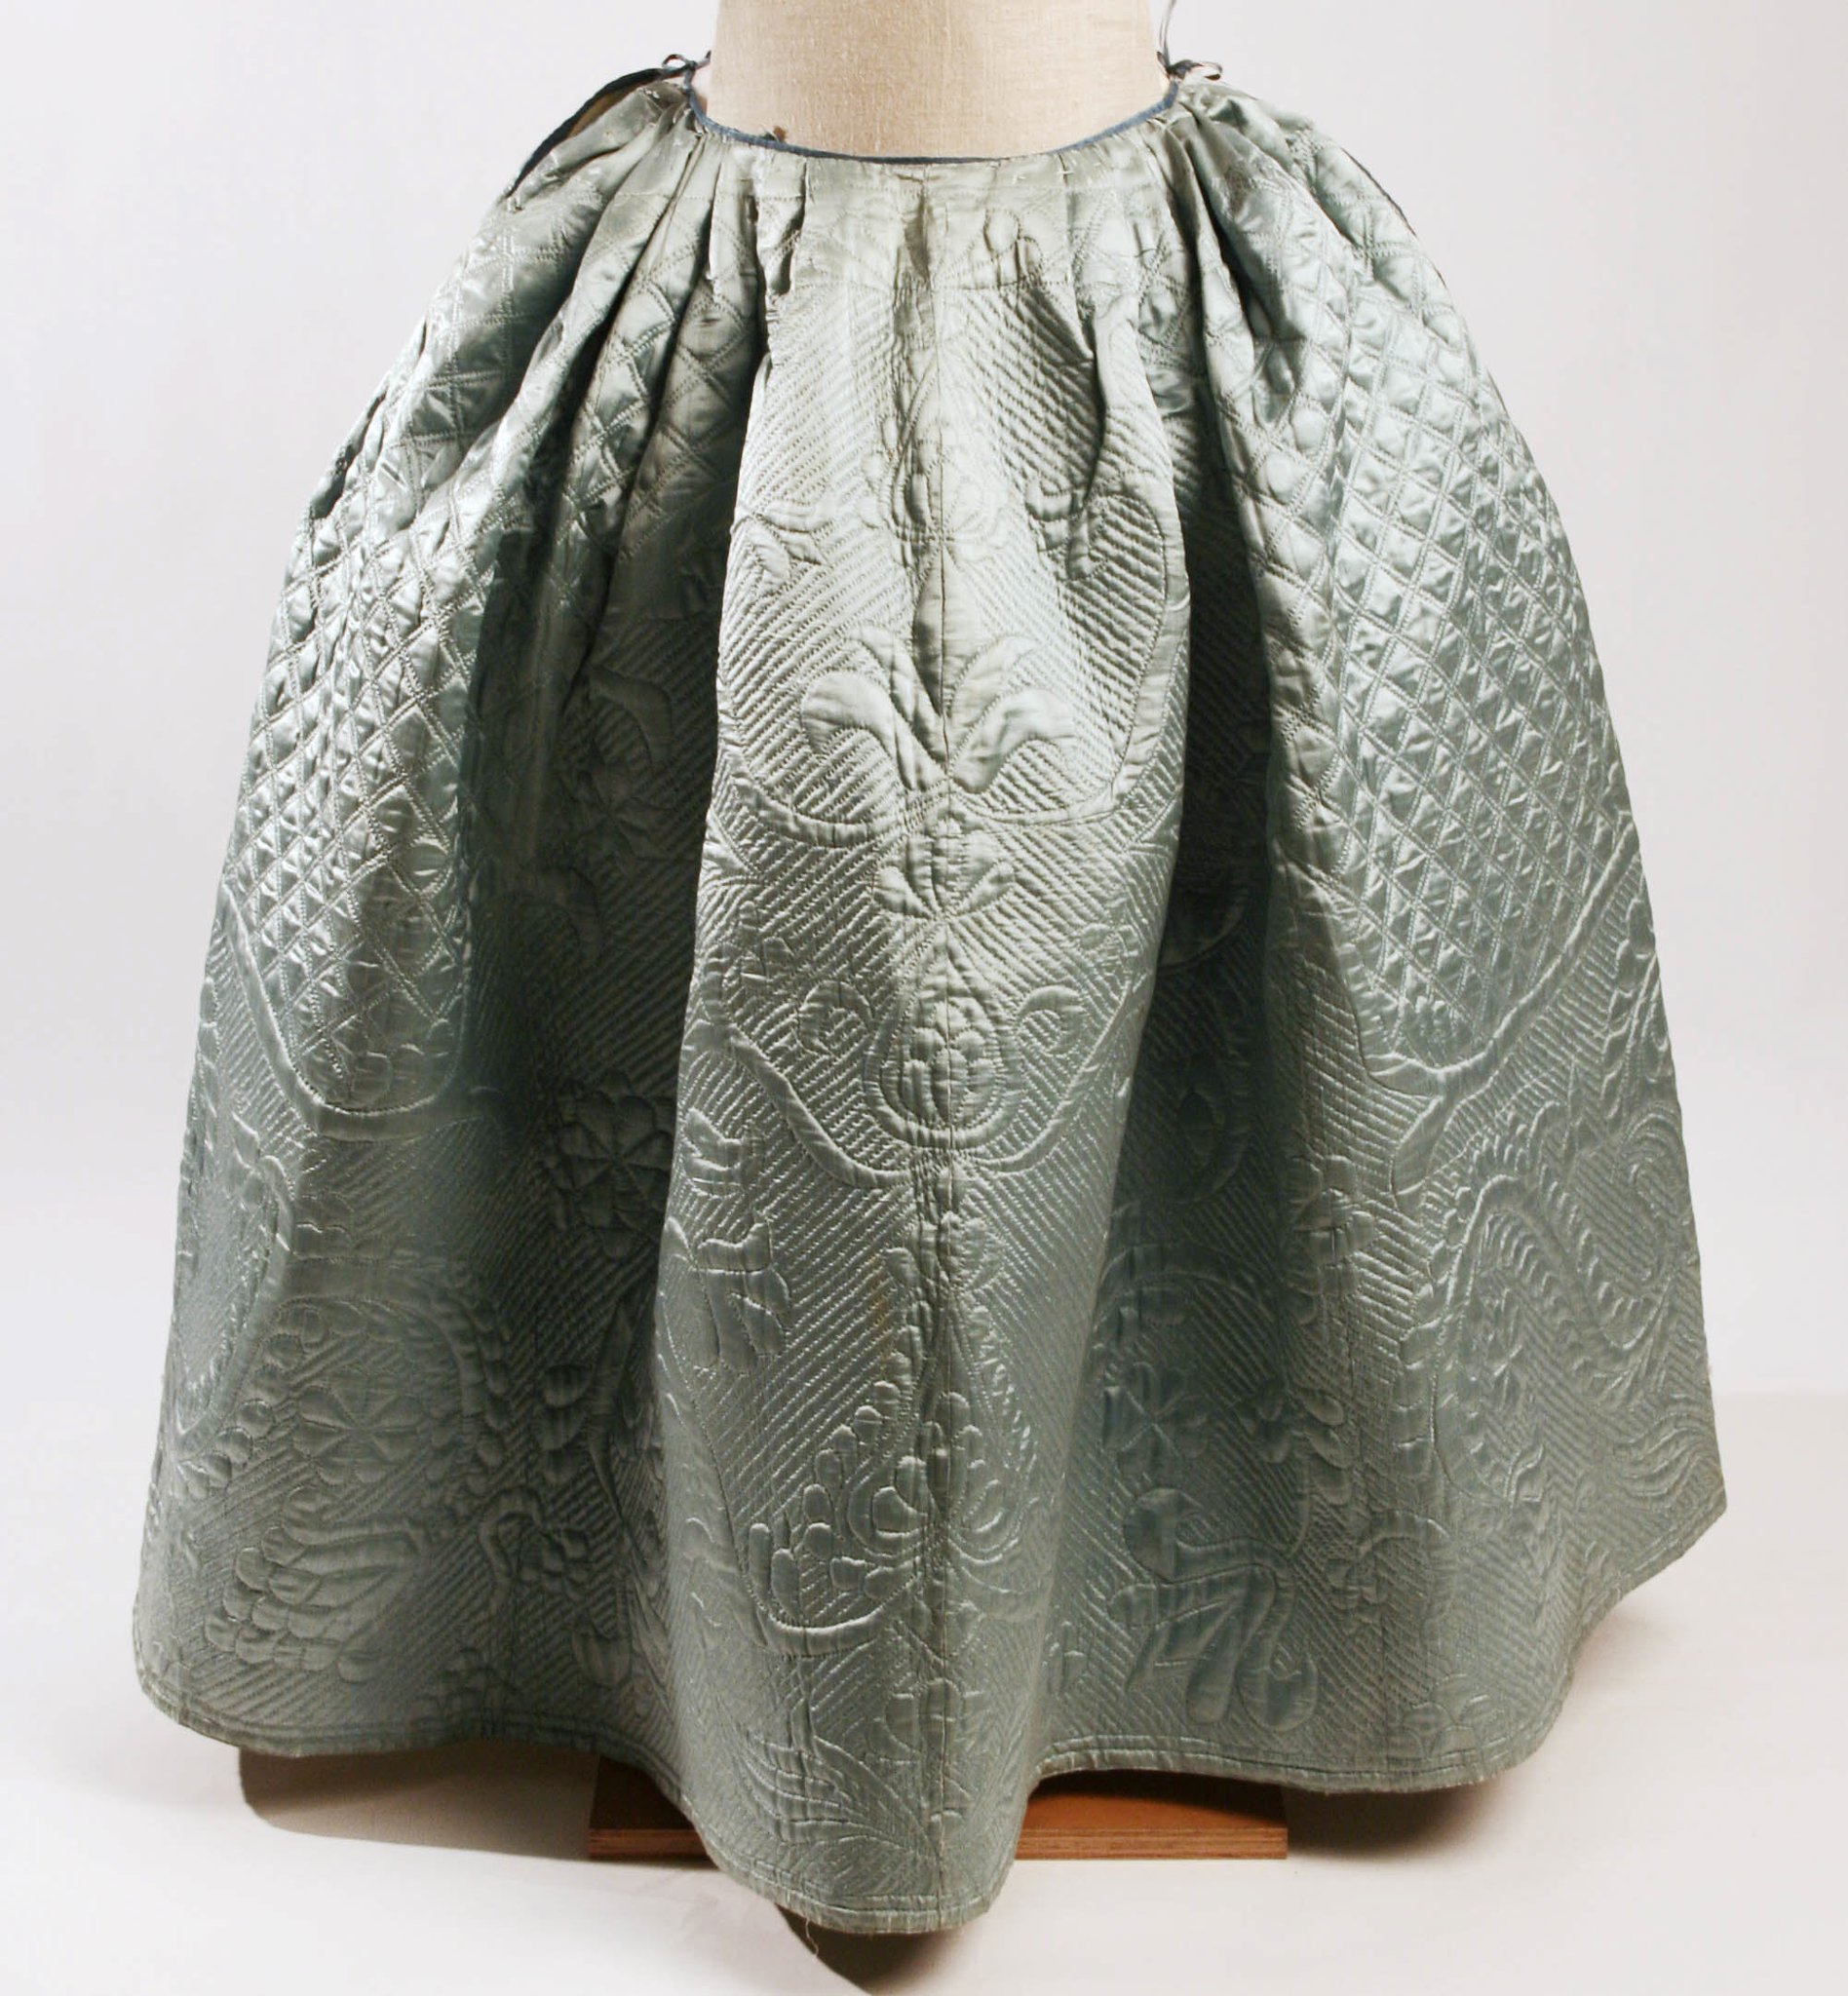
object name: petticoat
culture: american or european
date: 1750-1799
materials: silk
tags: flowers